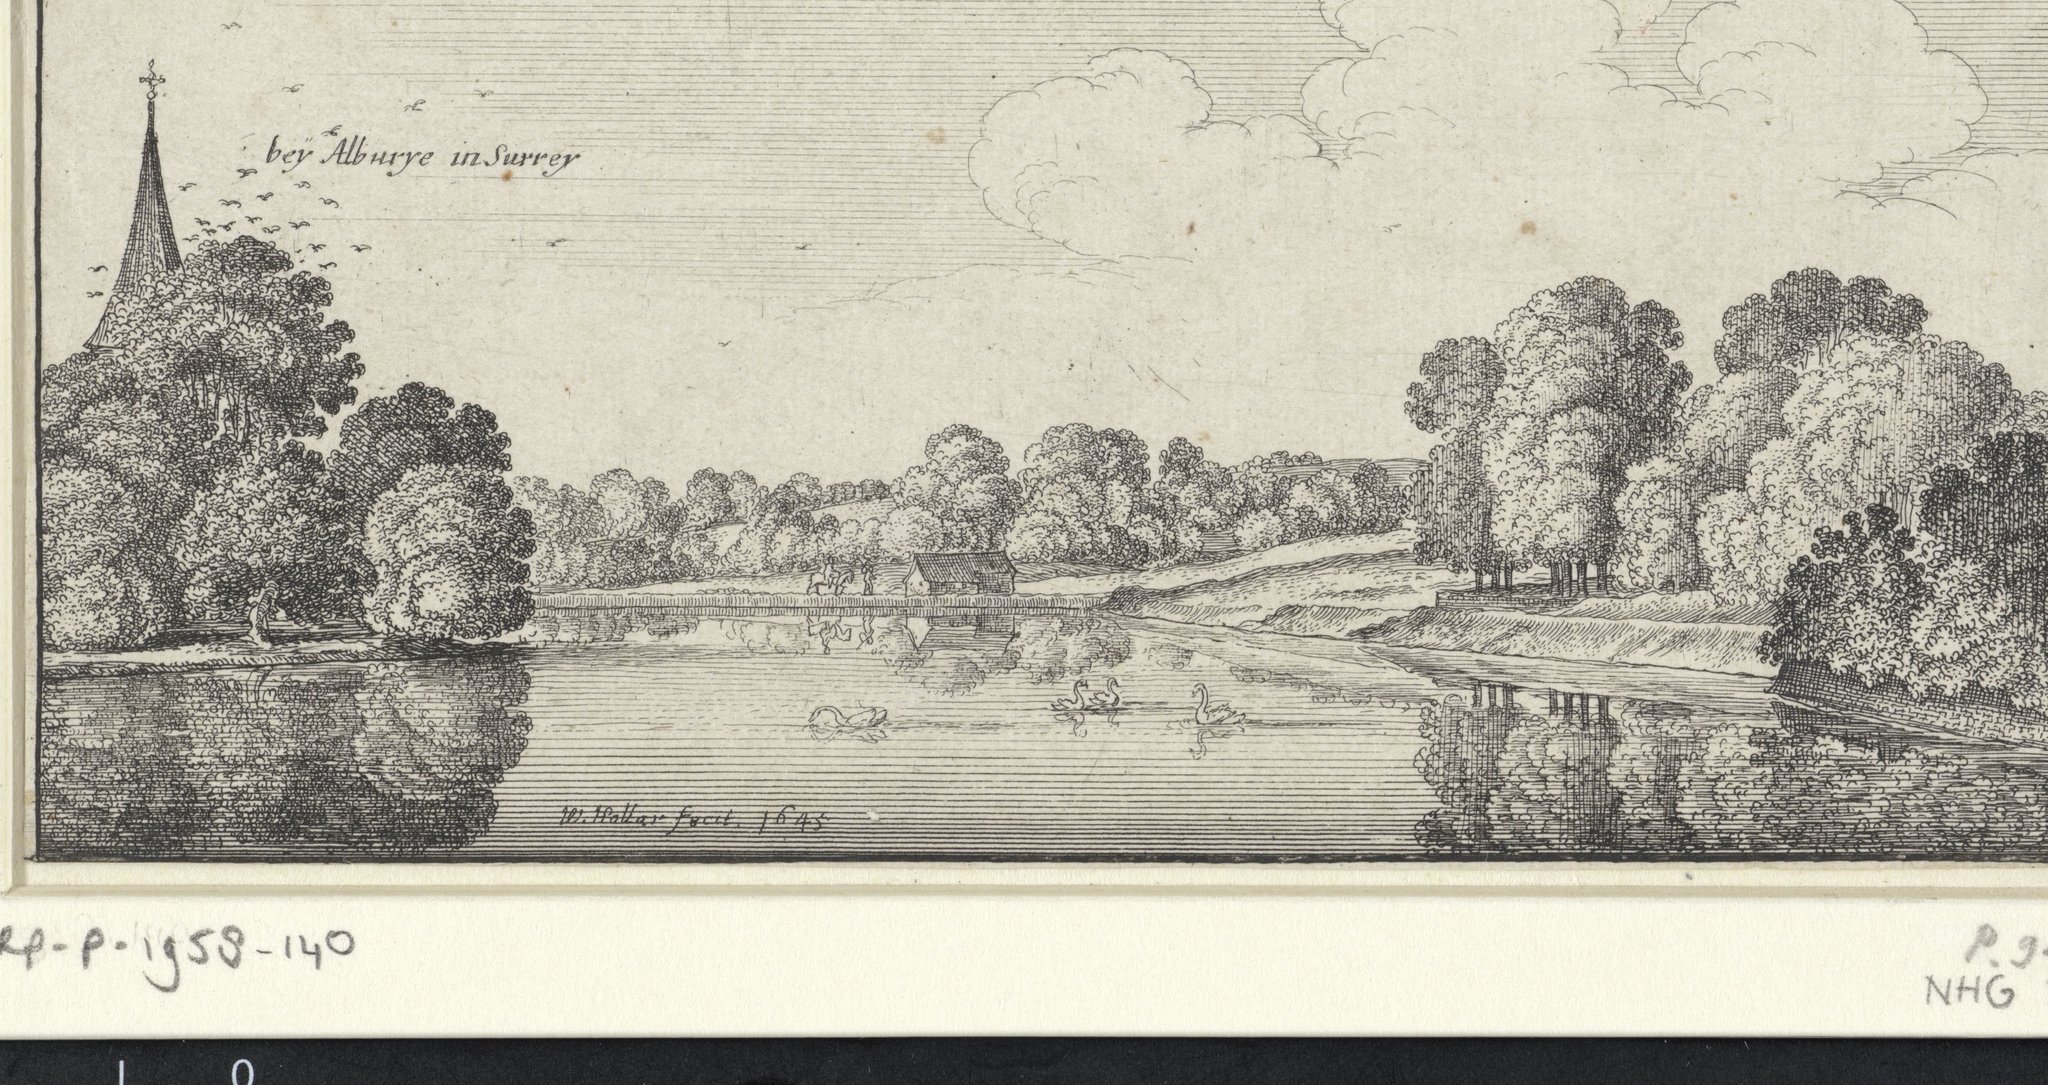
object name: print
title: Riviergezicht met zwanen nabij Albury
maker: wenceslaus hollar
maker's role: draughtsman, print maker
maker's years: 1607-1677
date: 1645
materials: paper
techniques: etching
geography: antwerp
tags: water-birds: swan, landscapes with waters, waterscapes, seascapes (in the temperate zone)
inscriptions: collector's mark: Lugt 2760, collector's mark: Lugt 533b, collector's mark: Lugt 2228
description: De prent maakt deel uit van een zesdelige serie met gezichten in de omgeving van Albury, Surrey.